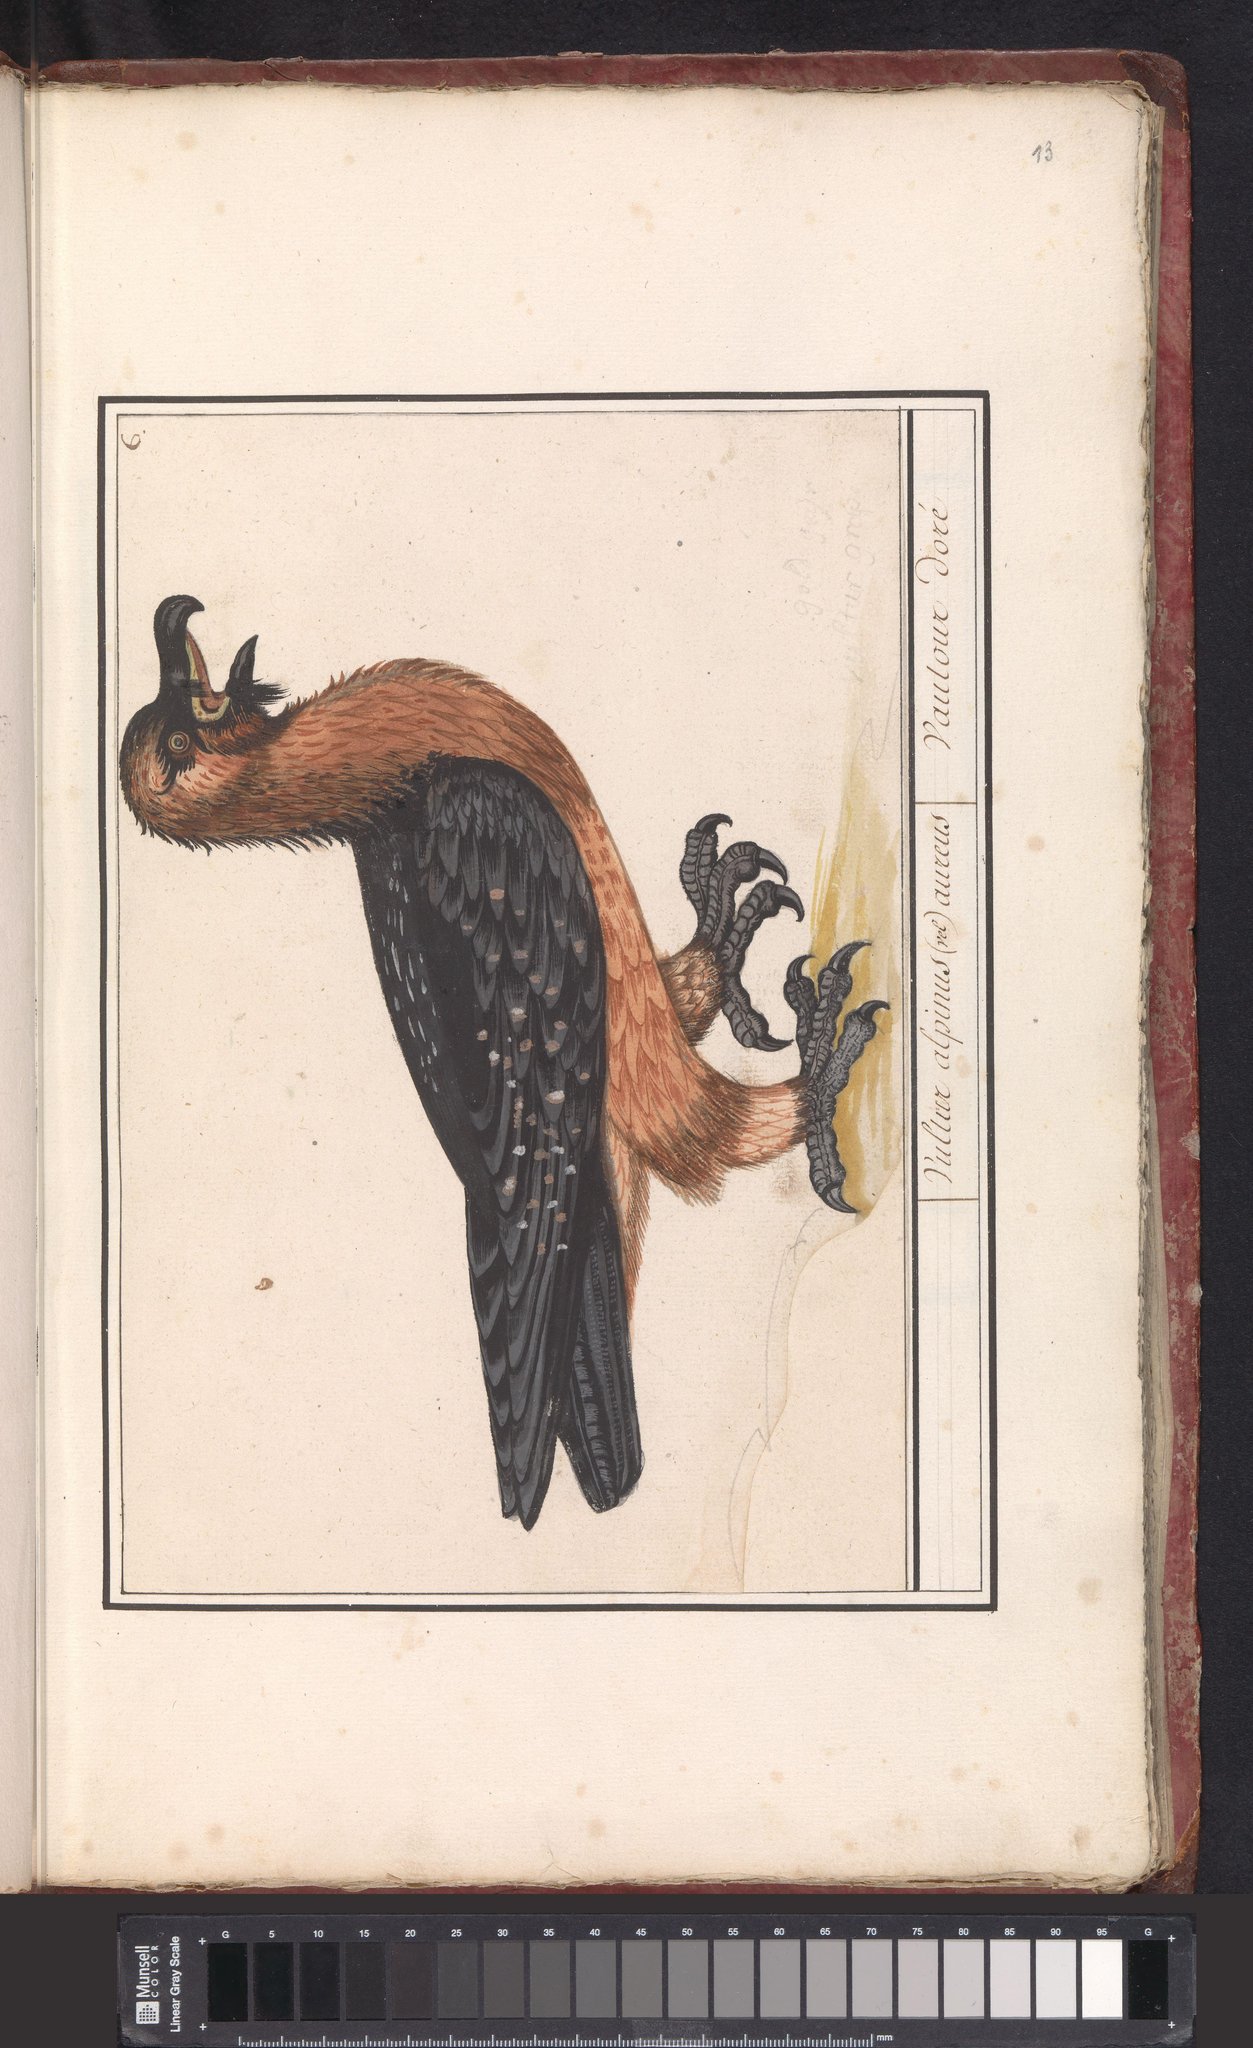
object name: drawing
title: Lammergier (Gypaetus barbatus)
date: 1596-1610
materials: paint, paper, pencil, watercolor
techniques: brush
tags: predatory birds: bearded vulture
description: Lammergier of baardgier. Genummerd rechtsboven: 6. Onderdeel van het eerste album met tekeningen van vogels. Derde van twaalf albums met tekeningen van dieren, vogels en planten bekend rond 1600, gemaakt in opdracht van keizer Rudolf II. Met toelichting in Nederlands, Latijn en Frans.